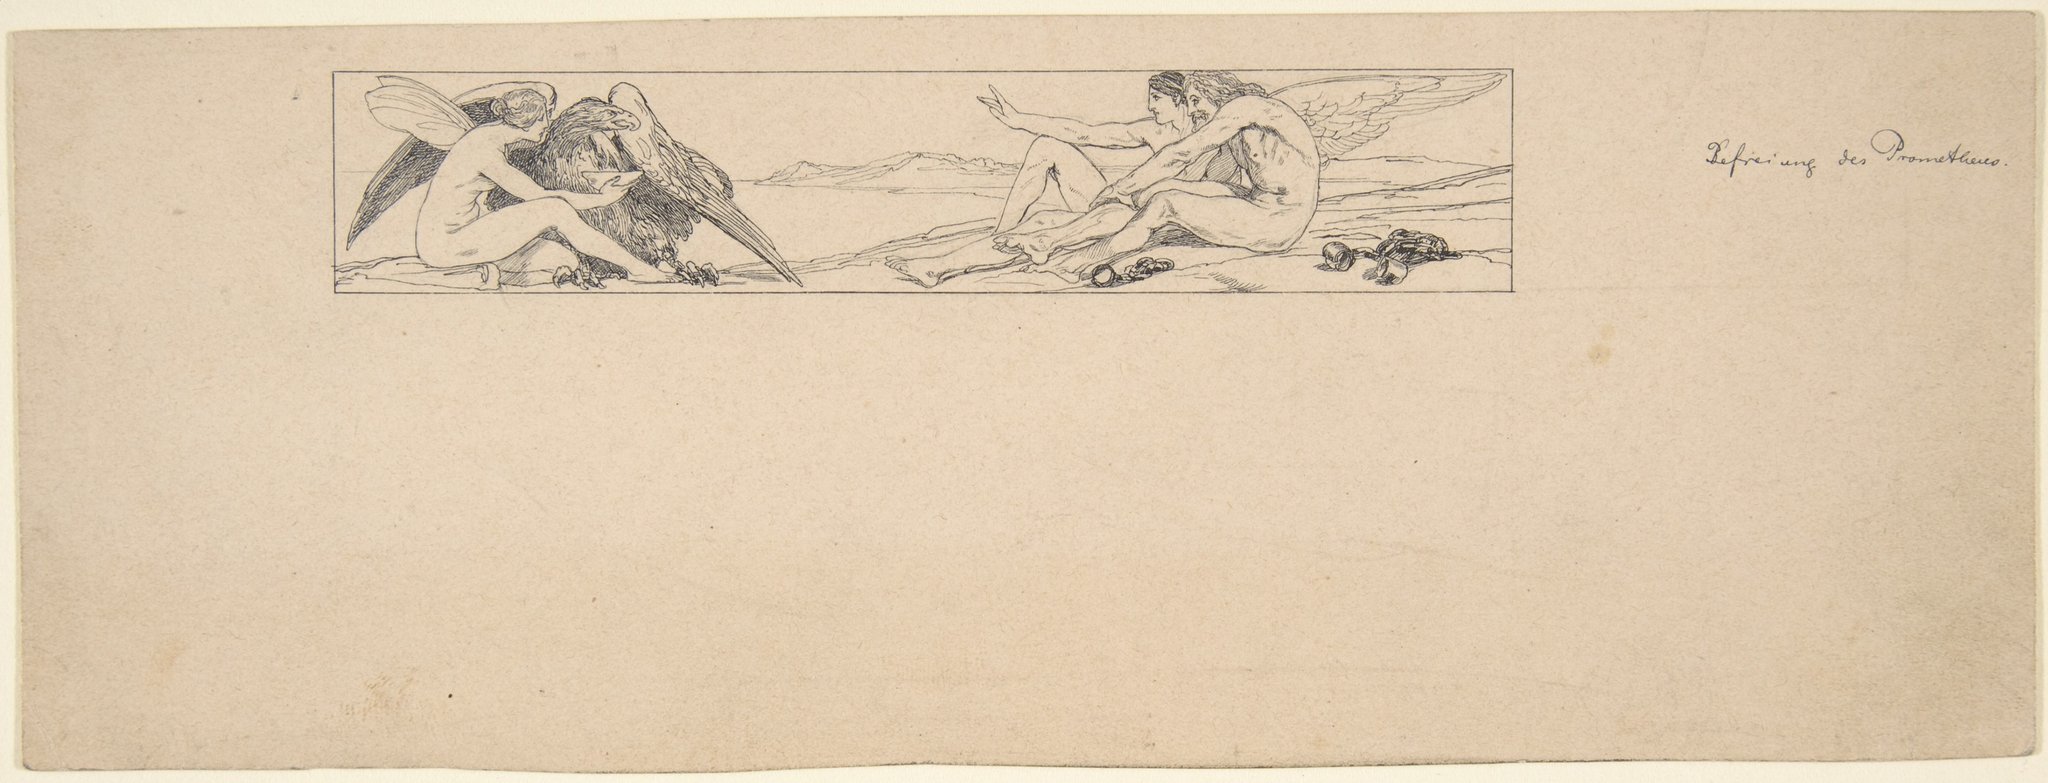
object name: drawing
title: The Release of Prometheus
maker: max klinger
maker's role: artist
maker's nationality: german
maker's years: 1857-1920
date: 1867-1933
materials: ink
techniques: pen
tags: eagles